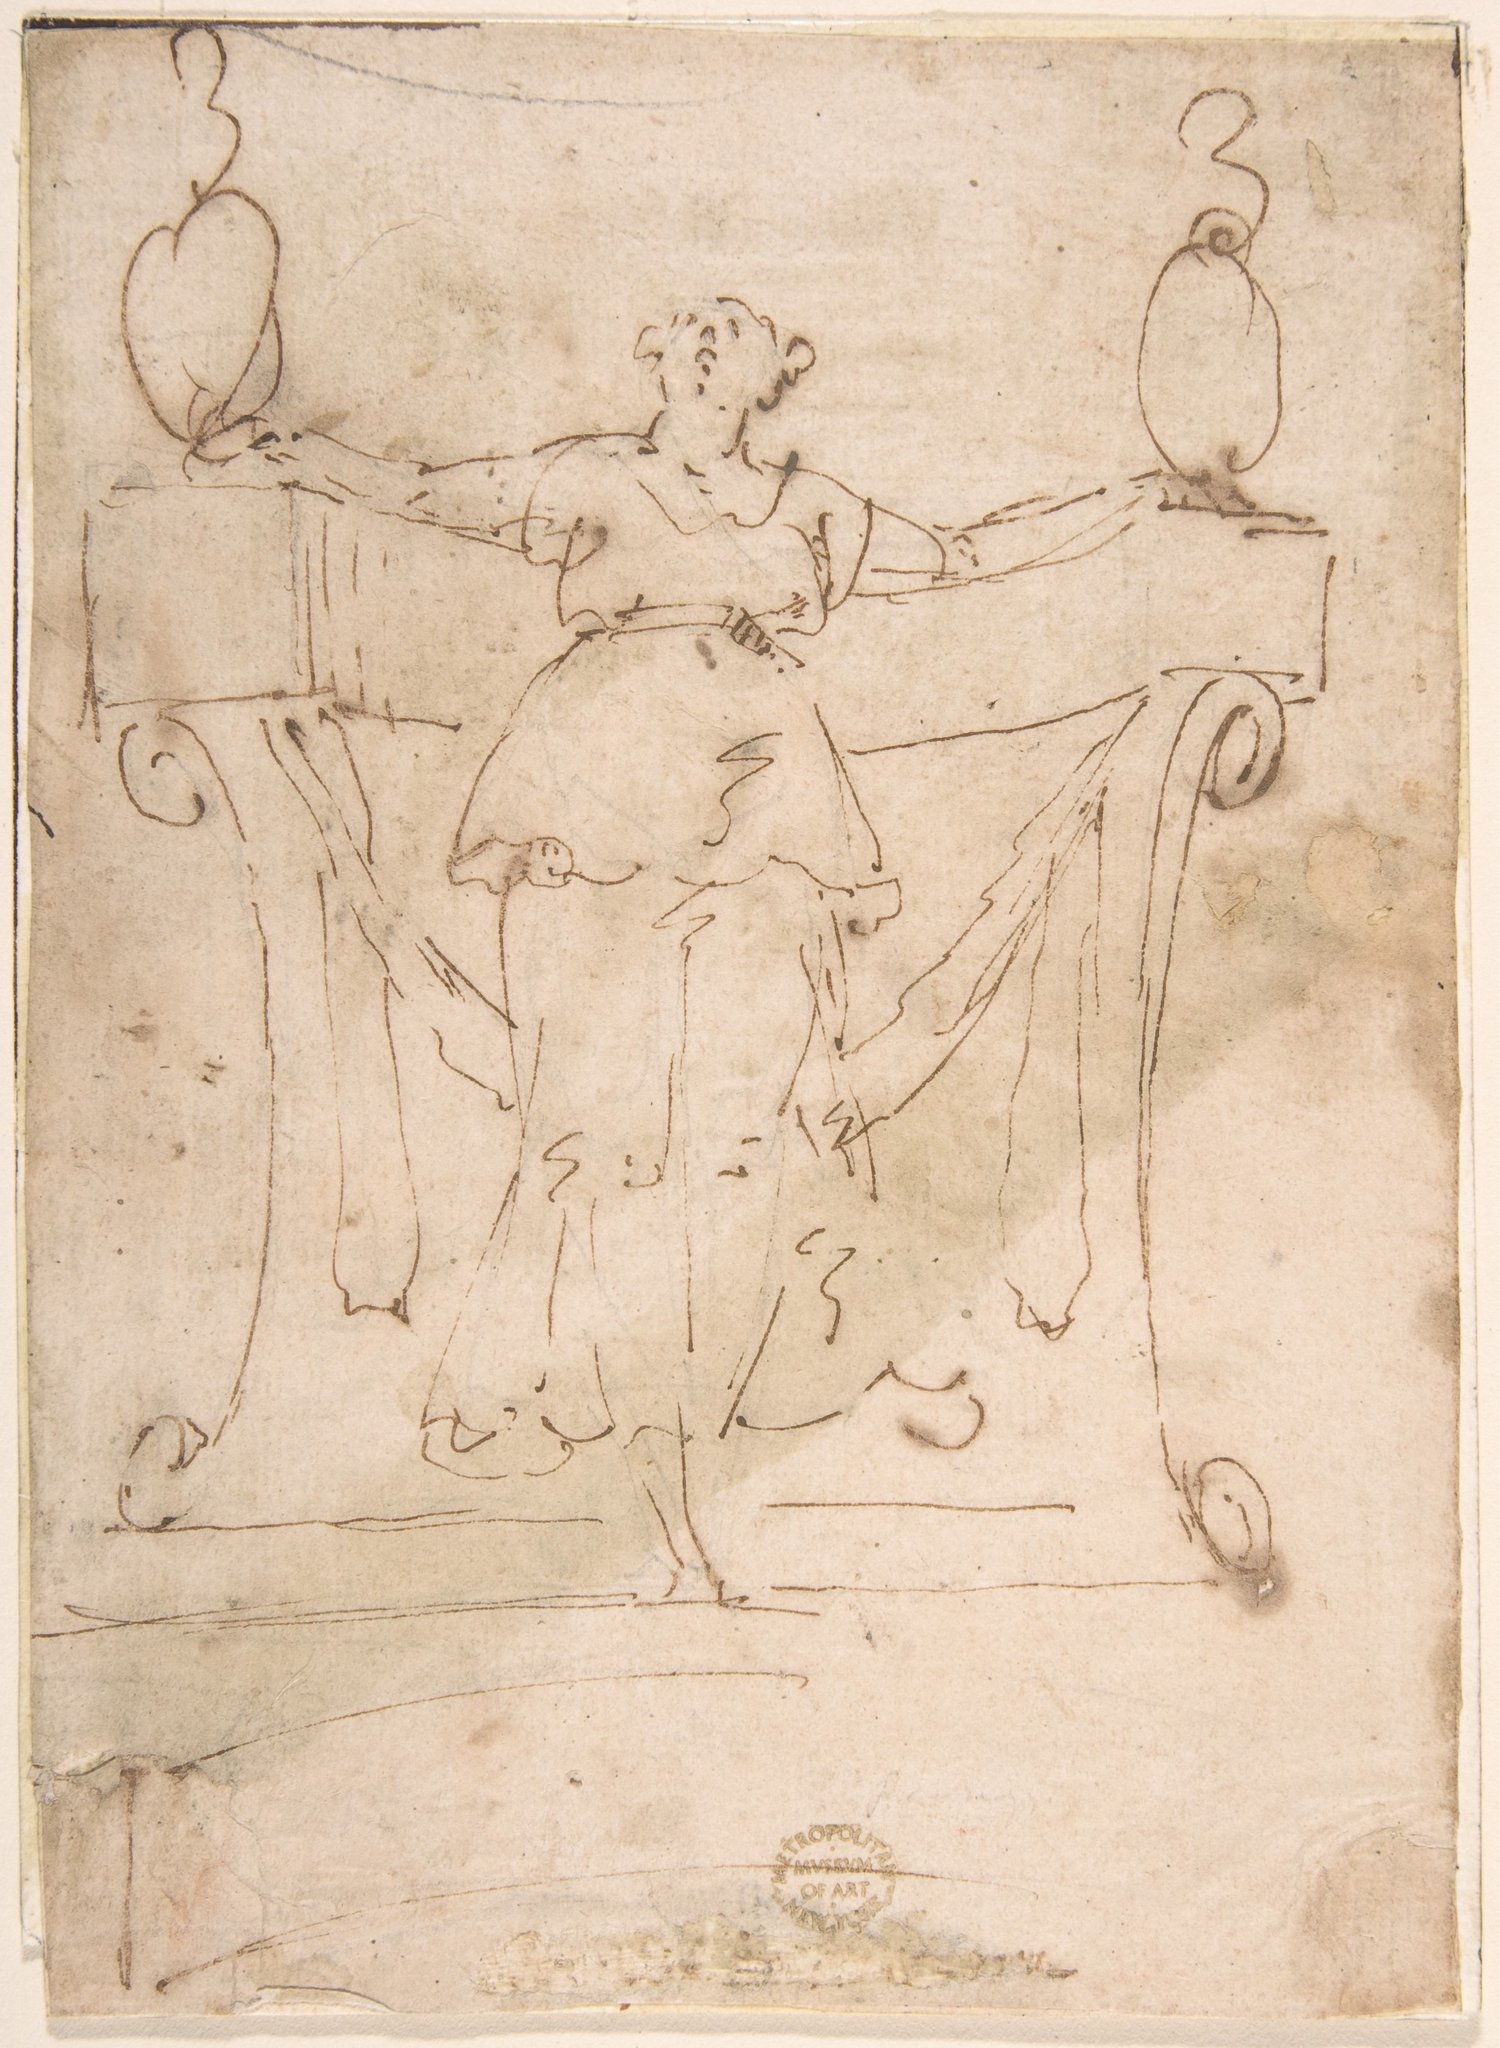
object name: drawing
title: Female Figure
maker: anonymous, italian, 16th century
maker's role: artist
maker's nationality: italian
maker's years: 1550-1600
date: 1501-1600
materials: ink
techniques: pen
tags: women